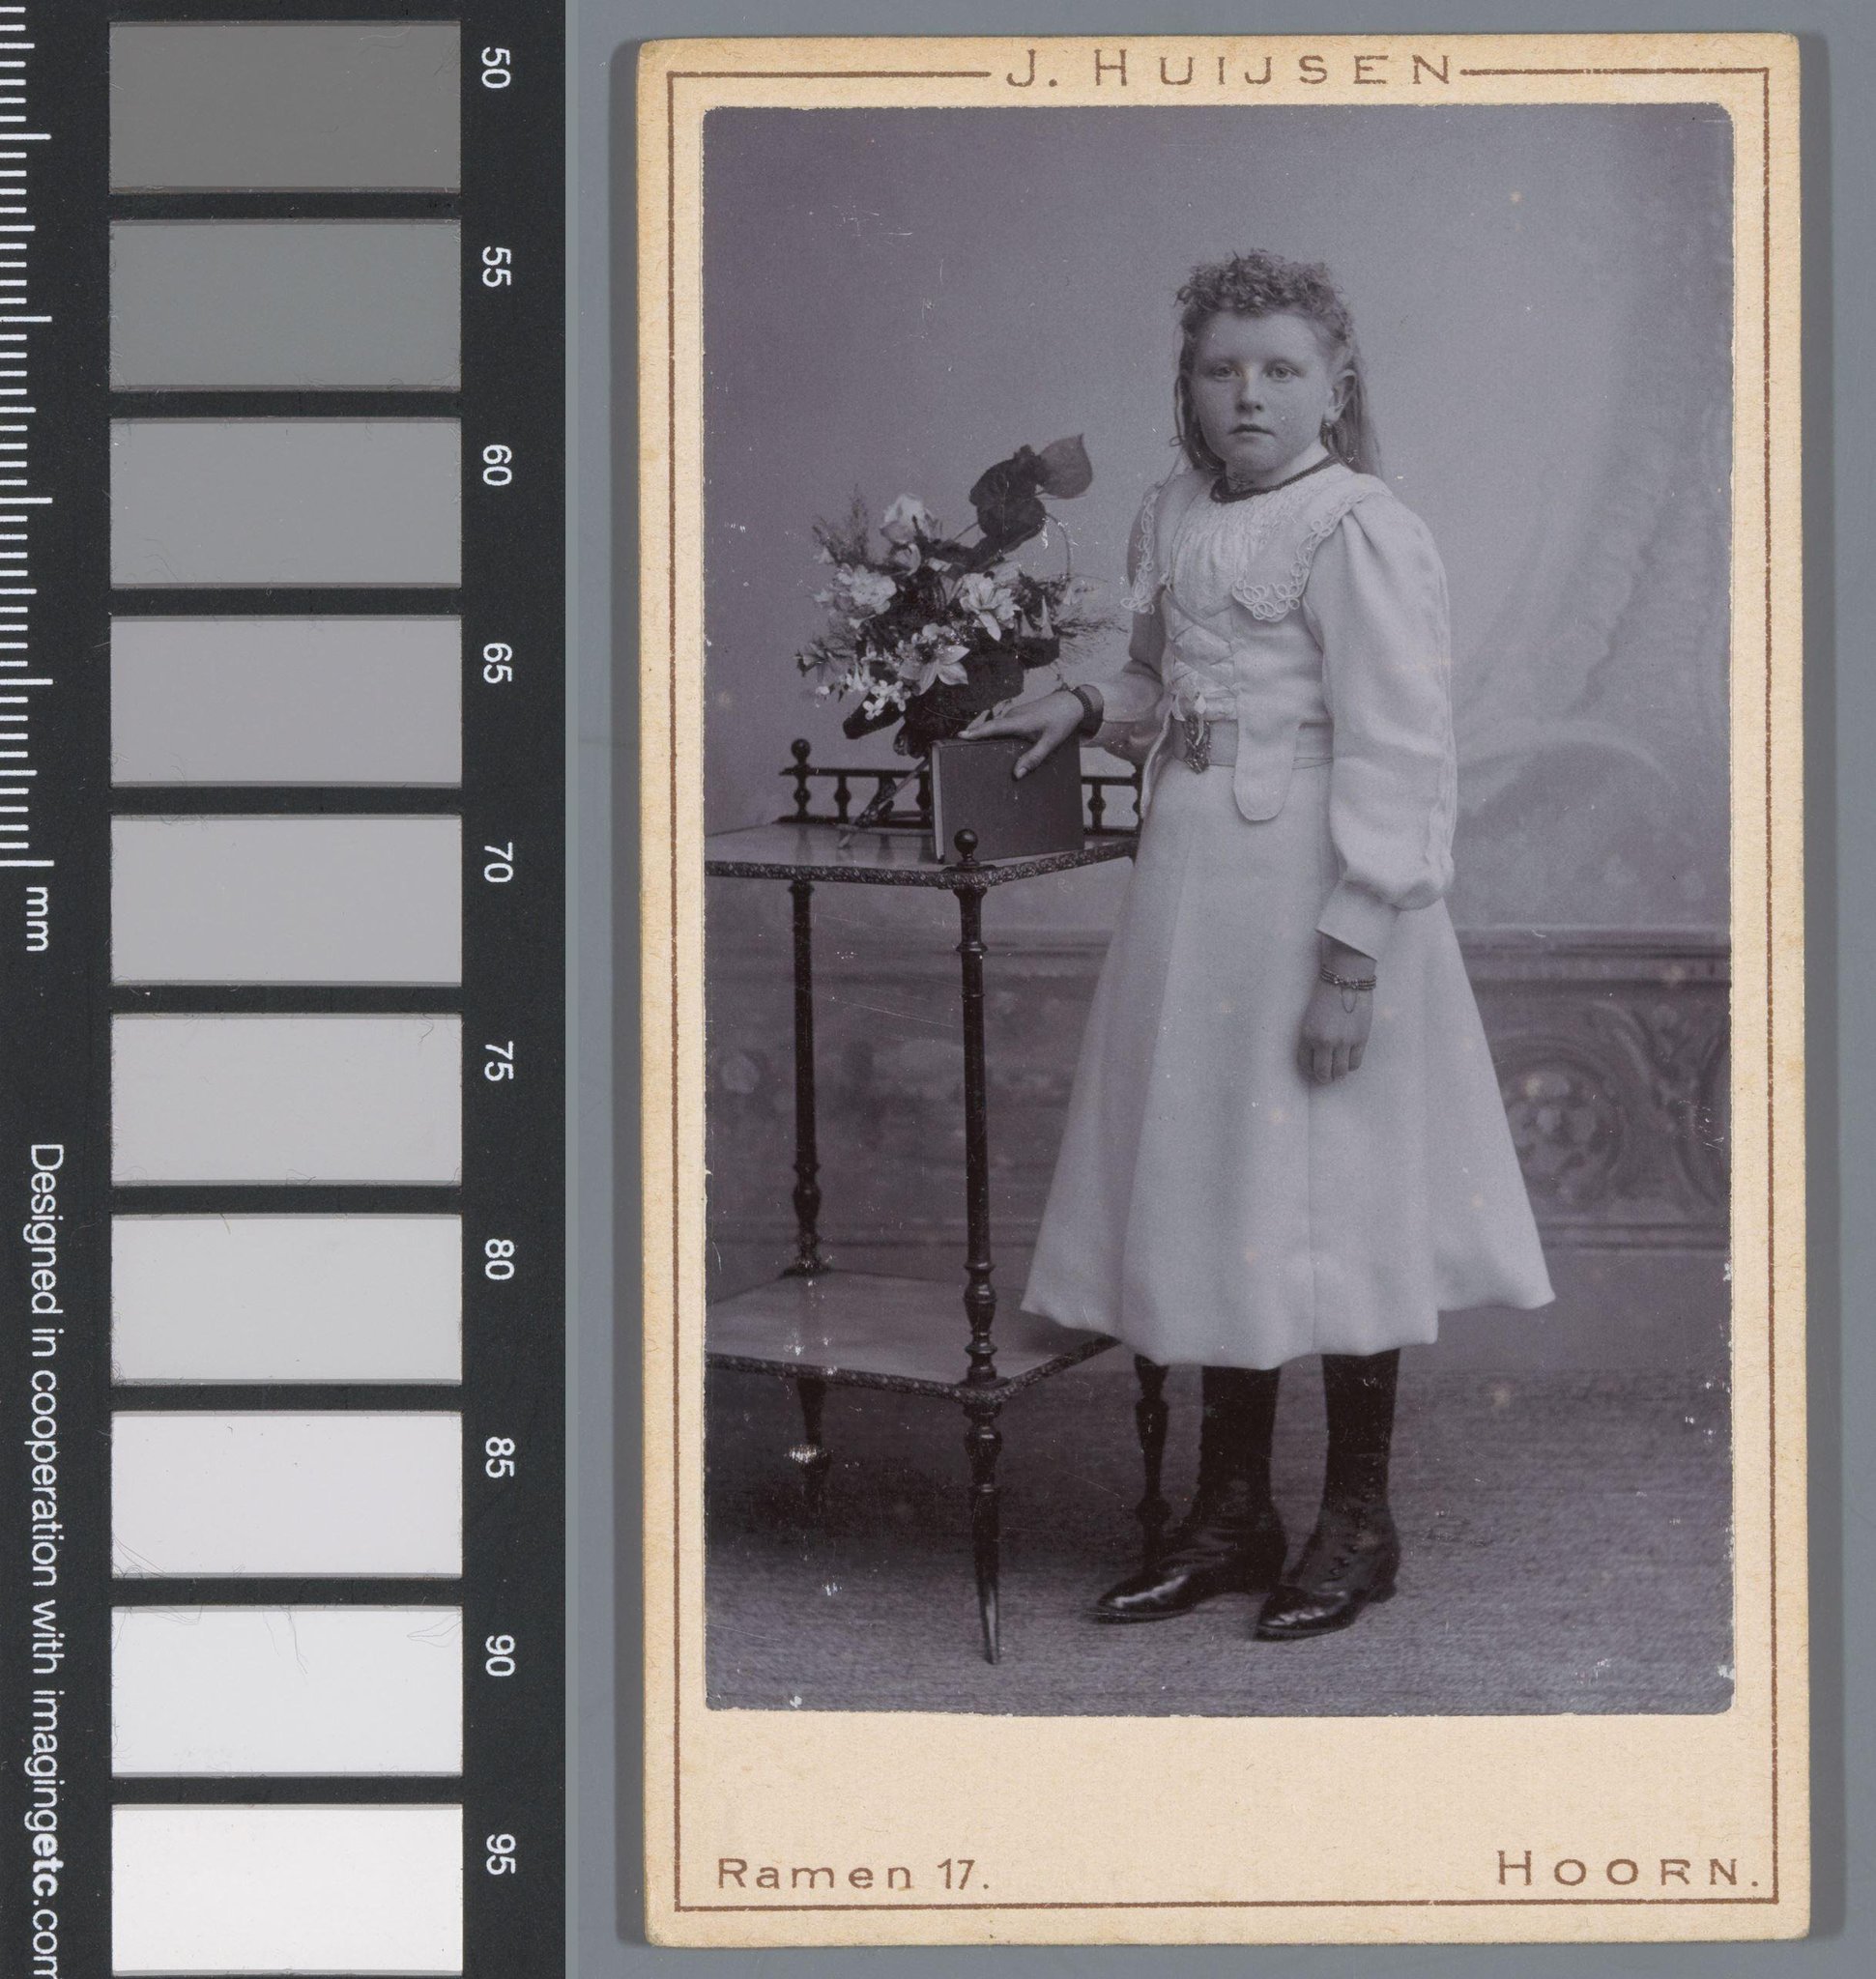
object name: photograph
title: Portret van Betje Haan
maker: johannes laurens theodorus huijsen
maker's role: fotograaf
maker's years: 1852-1910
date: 1883-1910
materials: cardboard, photographic support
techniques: collodion silver print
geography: hoorn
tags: flowers, historical persons, girl (child between toddler and youth), table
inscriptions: inscription: ‘J. L. T. HUIJSEN/ PHOTOGRAPHE/ Bekroond op verschillende/ Tentoonstellingen/ HOORN/ Ramen 17./ De plaat blijt ter nabestelling bewaard.’, inscription: ‘Betje Haan’